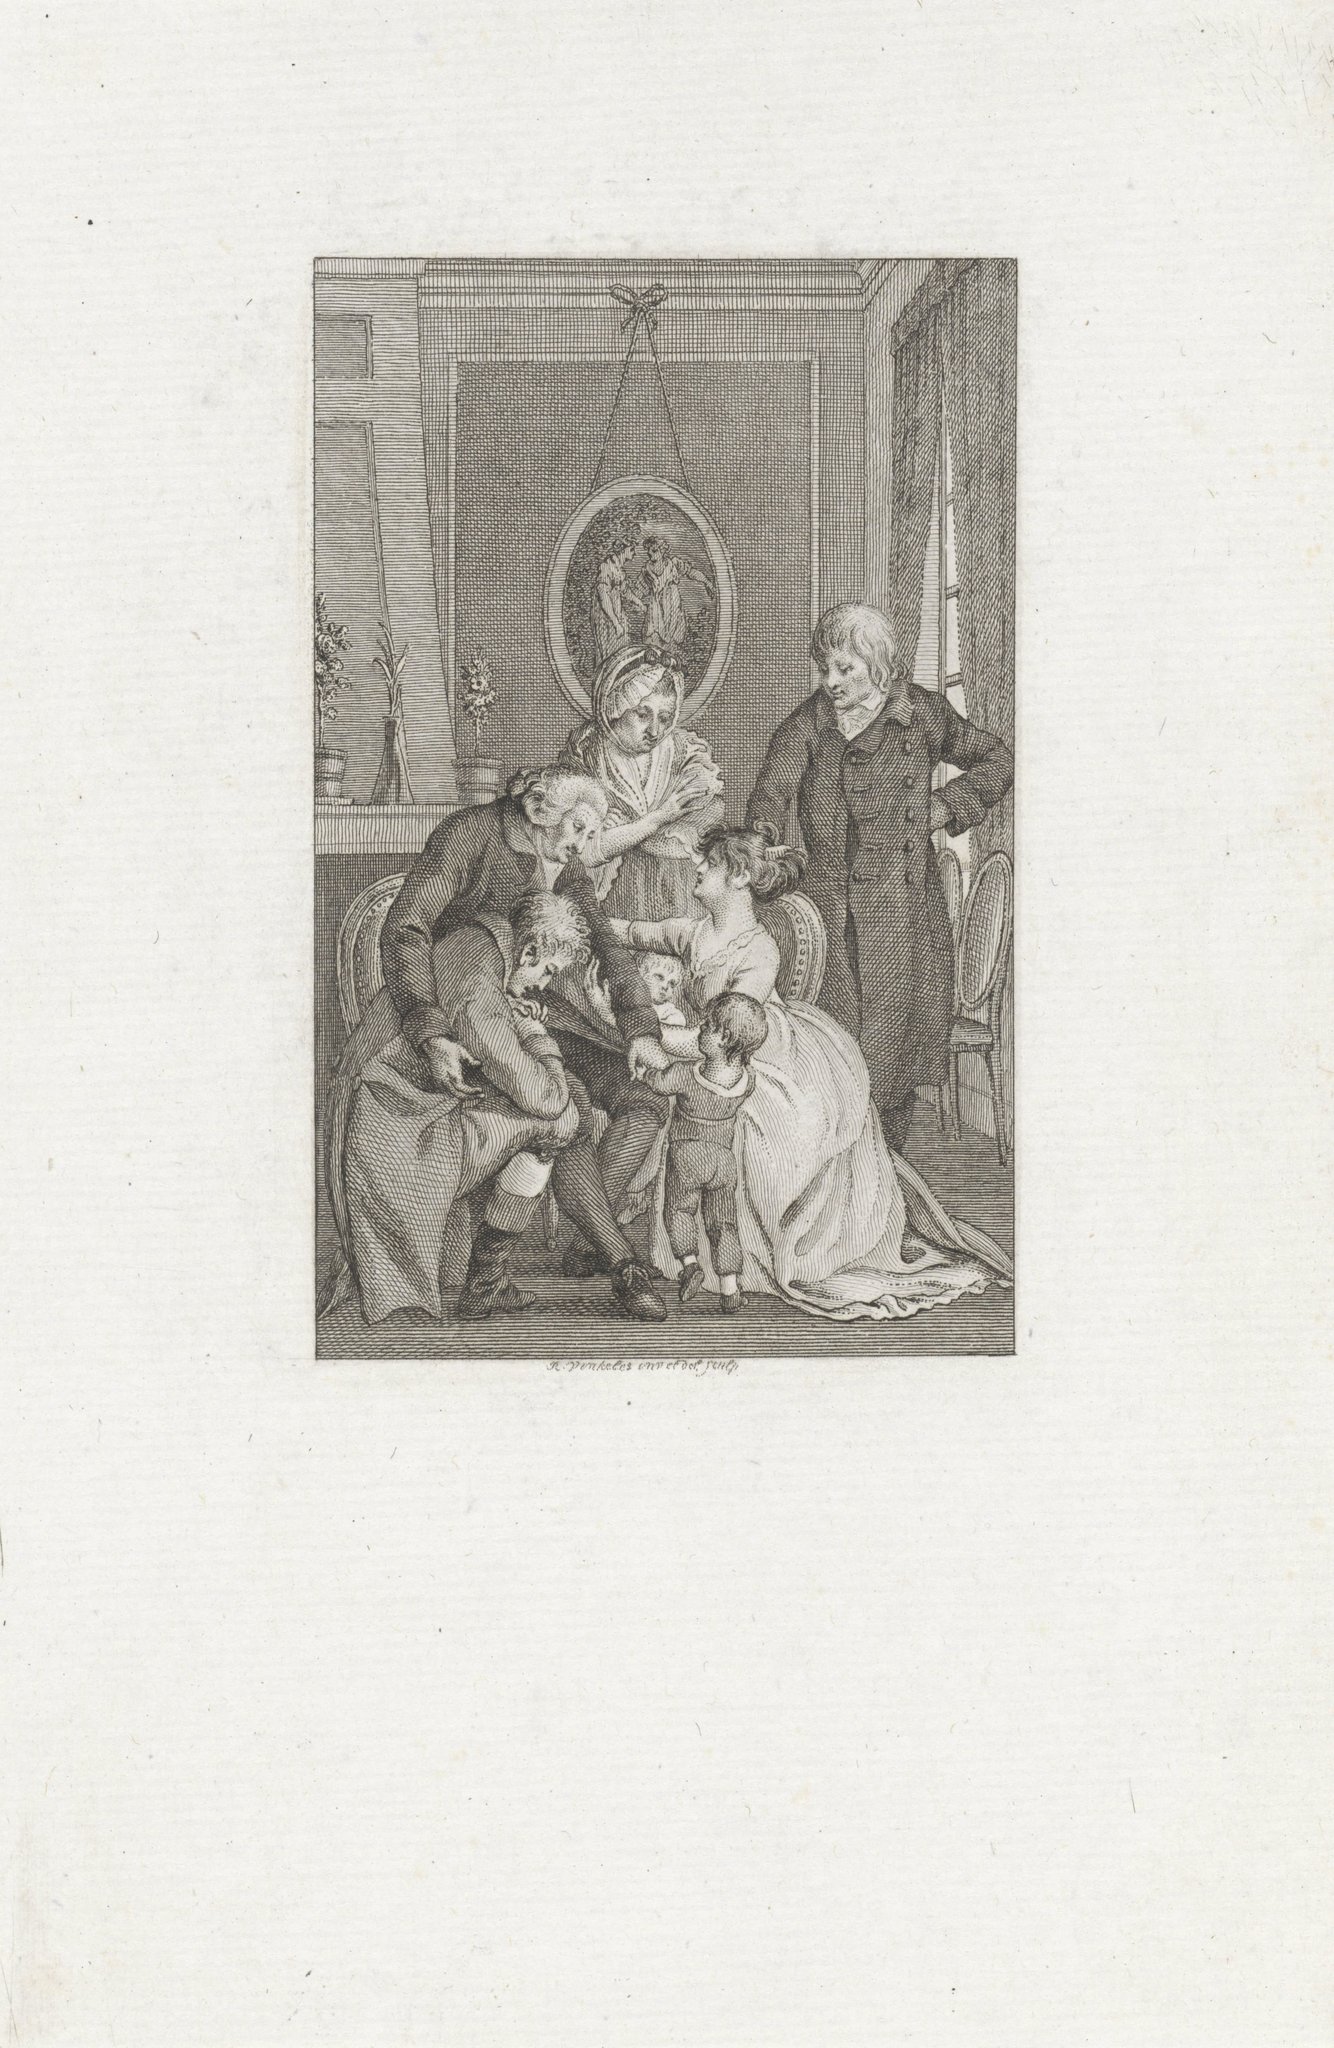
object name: print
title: Interieur met treurende familie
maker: reinier vinkeles (i)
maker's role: draughtsman, print maker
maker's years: 1741-1816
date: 1798-1811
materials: paper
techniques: engraving, etching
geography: amsterdam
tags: weeping, family, descendance, picture, painting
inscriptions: collector's mark: Lugt 240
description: Deze prent is ook als illustratie gebruikt in: Magazijn van Geschiedenissen, romans en verhalen, 25 delen. Rotterdam: Jan Meyer, 1790-1798 en Amsterdam: Johannes Allart, 1798-1811.